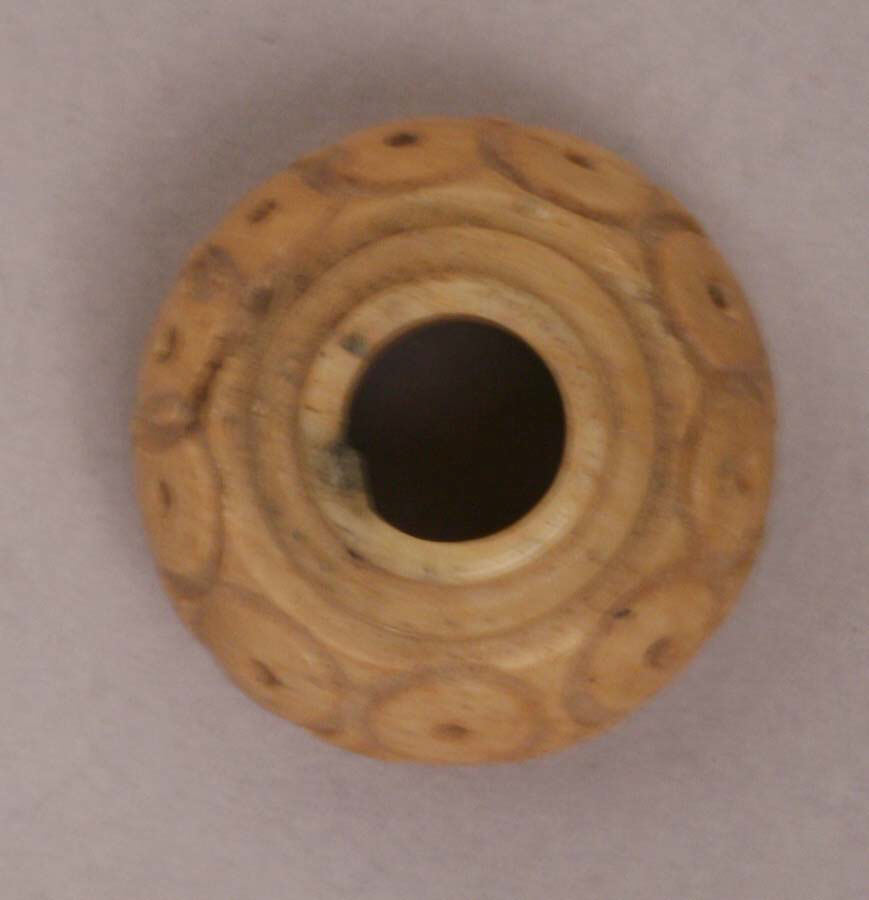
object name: button or bead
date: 801-1000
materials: bone, paint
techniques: incising, inlay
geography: iran